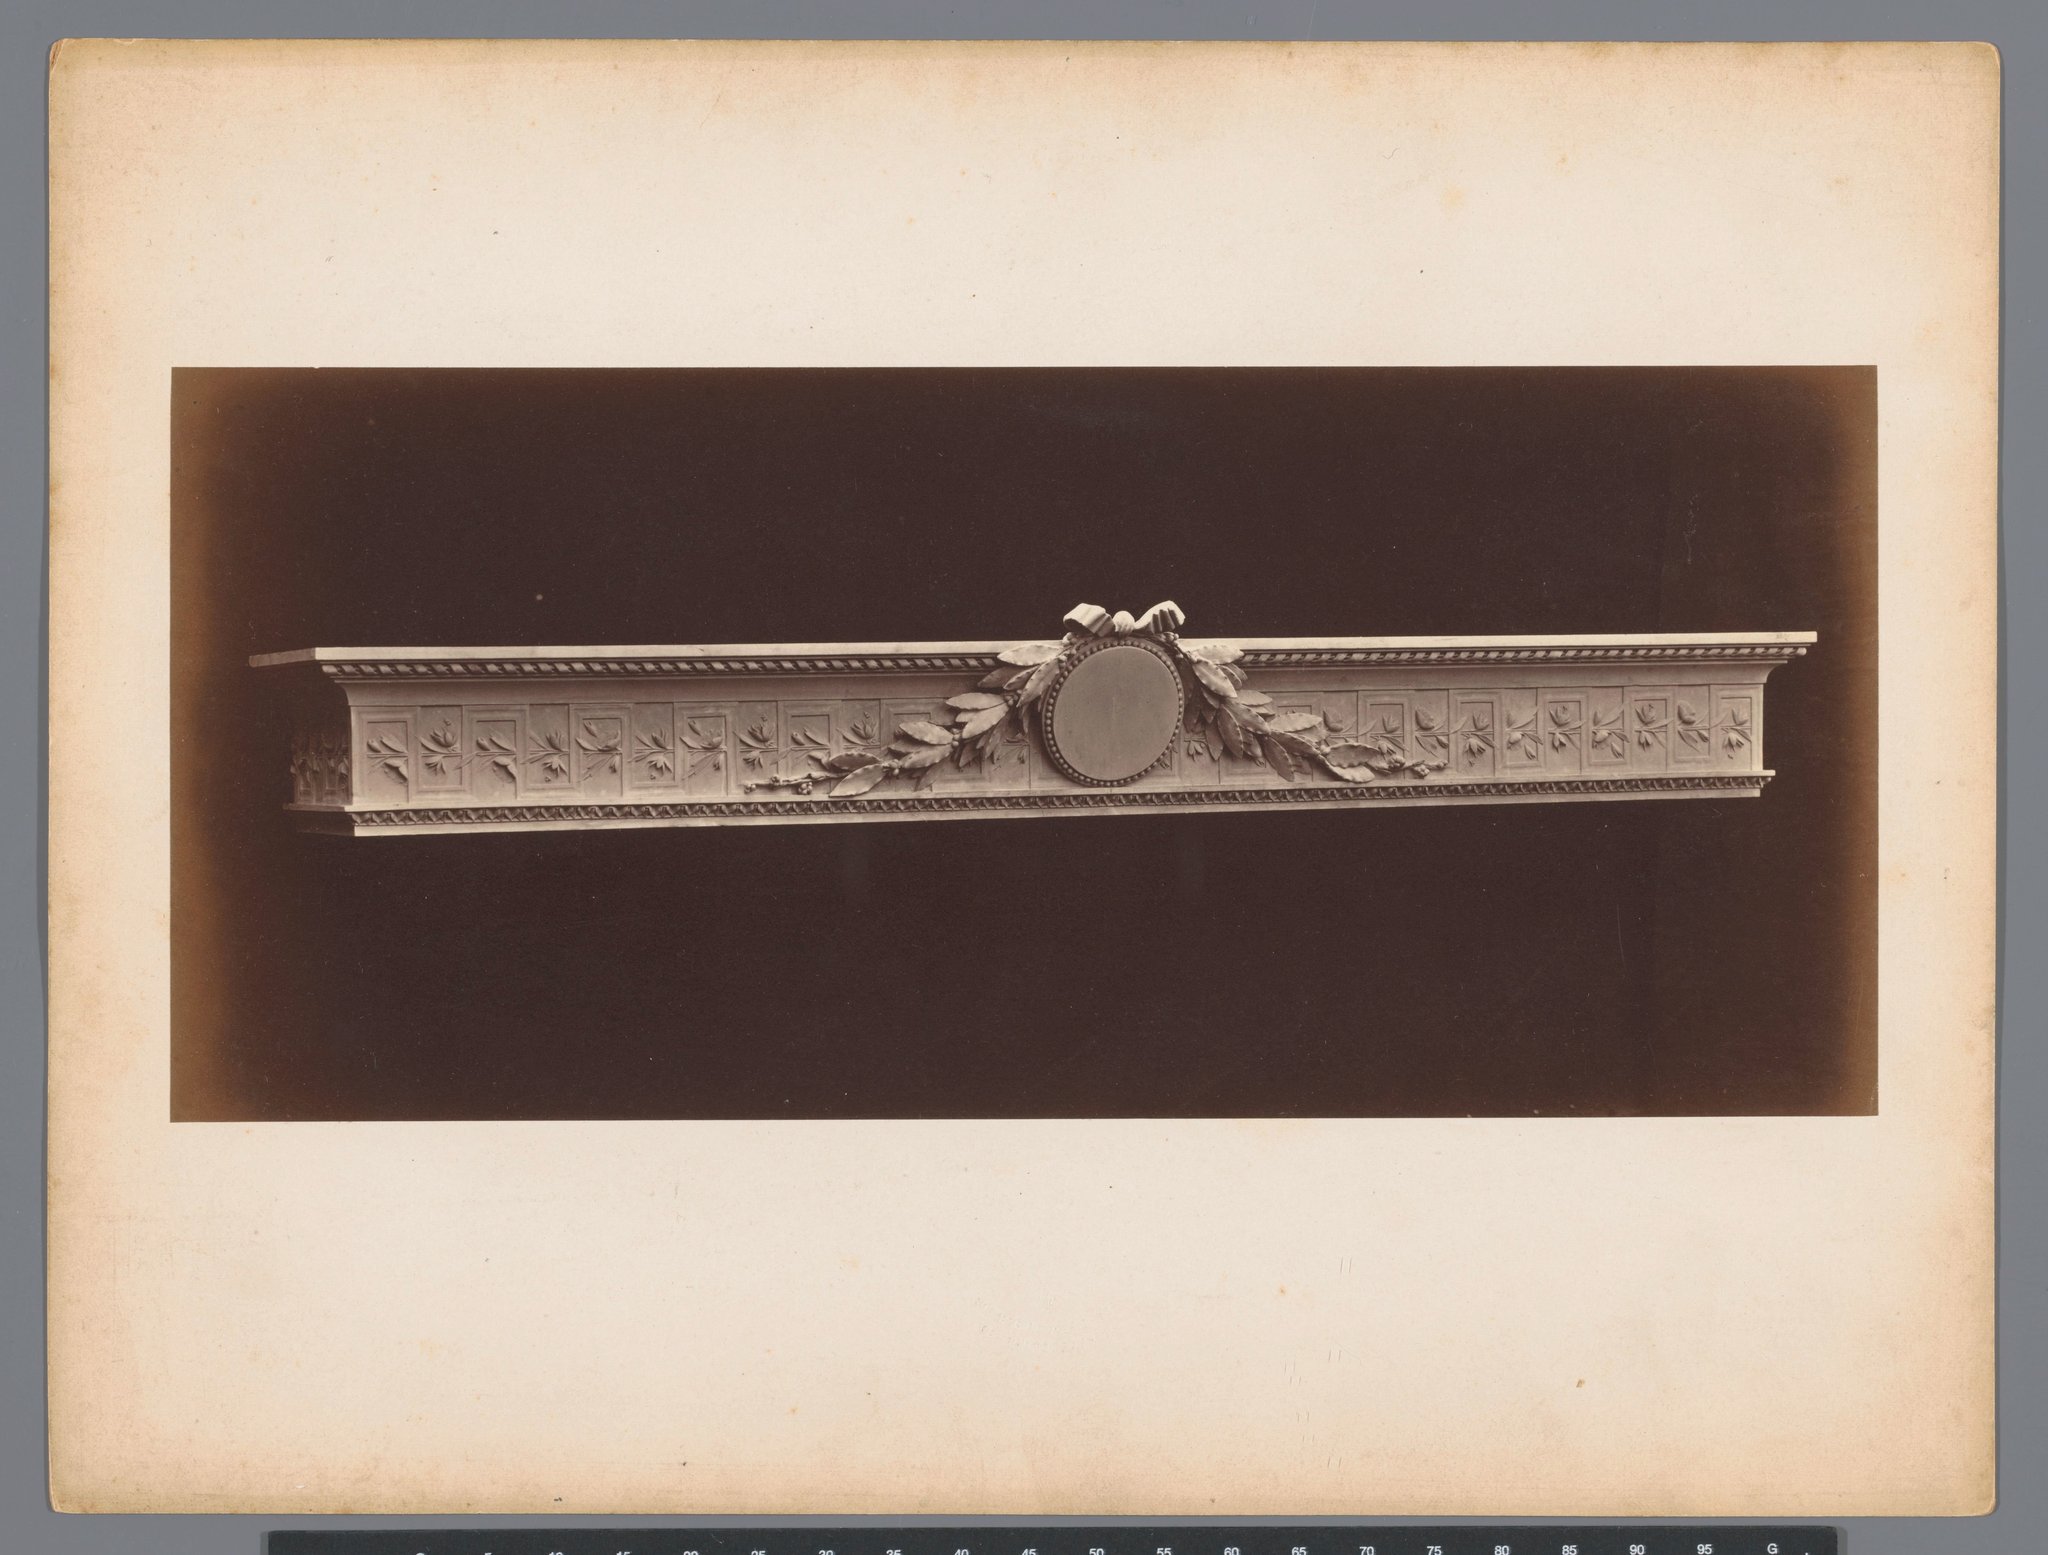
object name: photograph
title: Kroonlijst met medaillon en twee lauriertakken, waarschijnlijk een productfoto van een fabrikant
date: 1862-1900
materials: cardboard, paper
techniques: albumen print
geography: belgium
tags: architectural detail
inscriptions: inscription: ‘geschenk MB’, inscription: ‘200-’